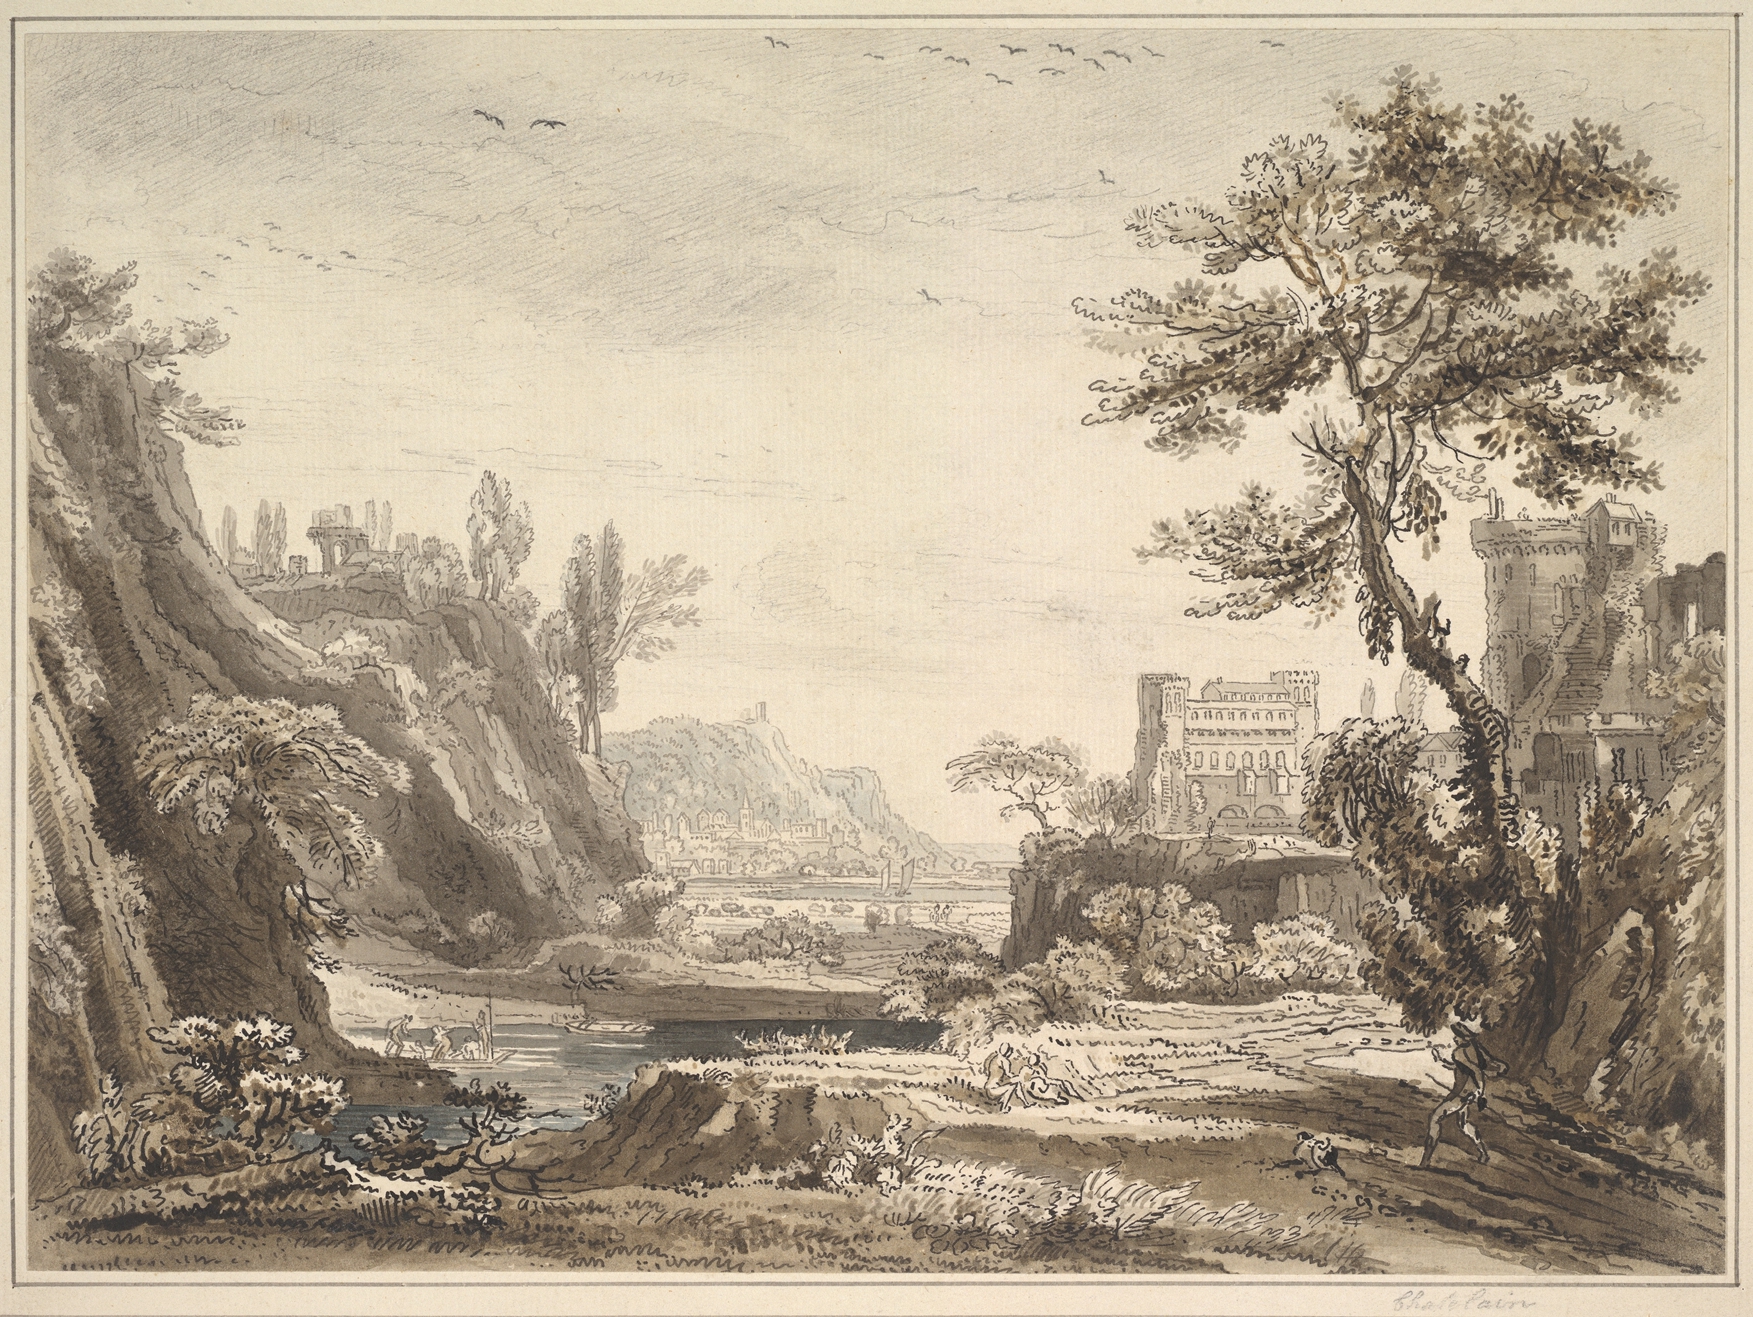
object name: drawing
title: A classical landscape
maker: jean-baptiste-claude chatelain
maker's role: artist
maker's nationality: british, french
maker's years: 1705-1758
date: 1730-1758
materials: graphite, ink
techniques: brush, pen, wash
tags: landscapes,trees